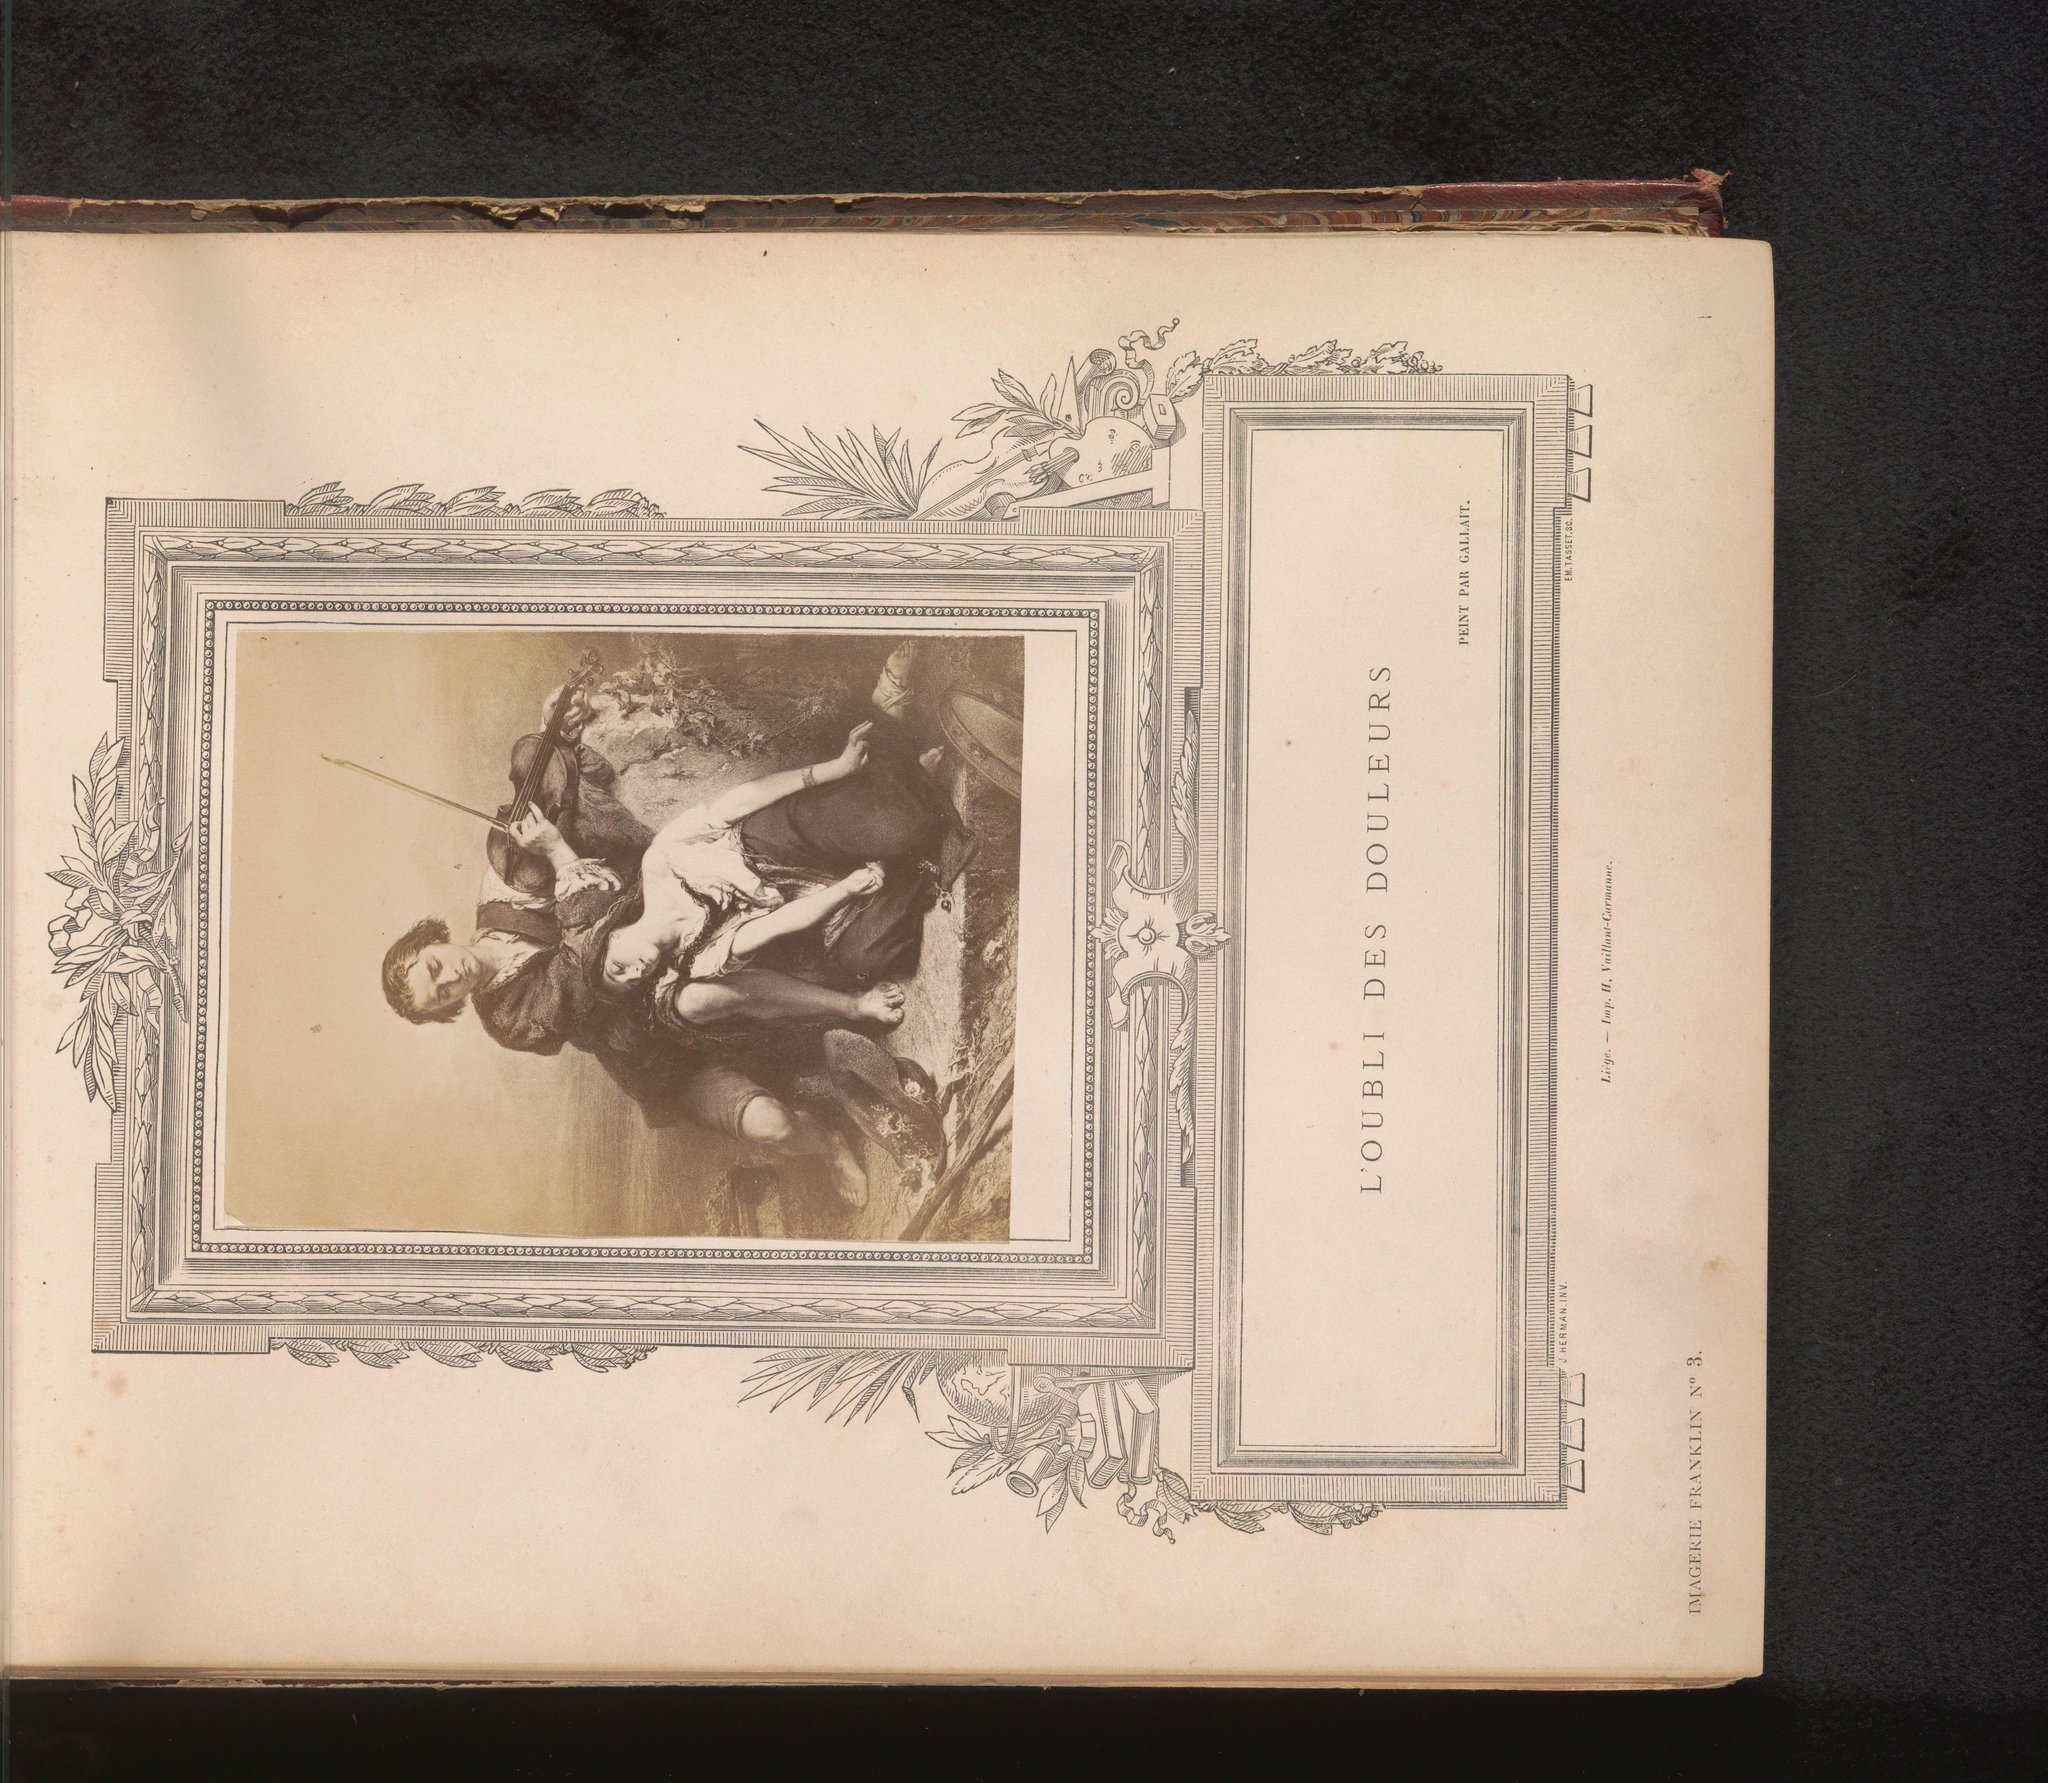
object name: reproduction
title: L'oubli des Douleurs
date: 1871-1880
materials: photographic support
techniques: albumen print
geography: liège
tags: violin, fiddle (+ artist at work), couple of lovers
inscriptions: name: ‘EM. TASSET, SC.’, inscription: ‘IMAGERIE FRANKLIN No 3.’, name: ‘J. HERMAN, INV.’